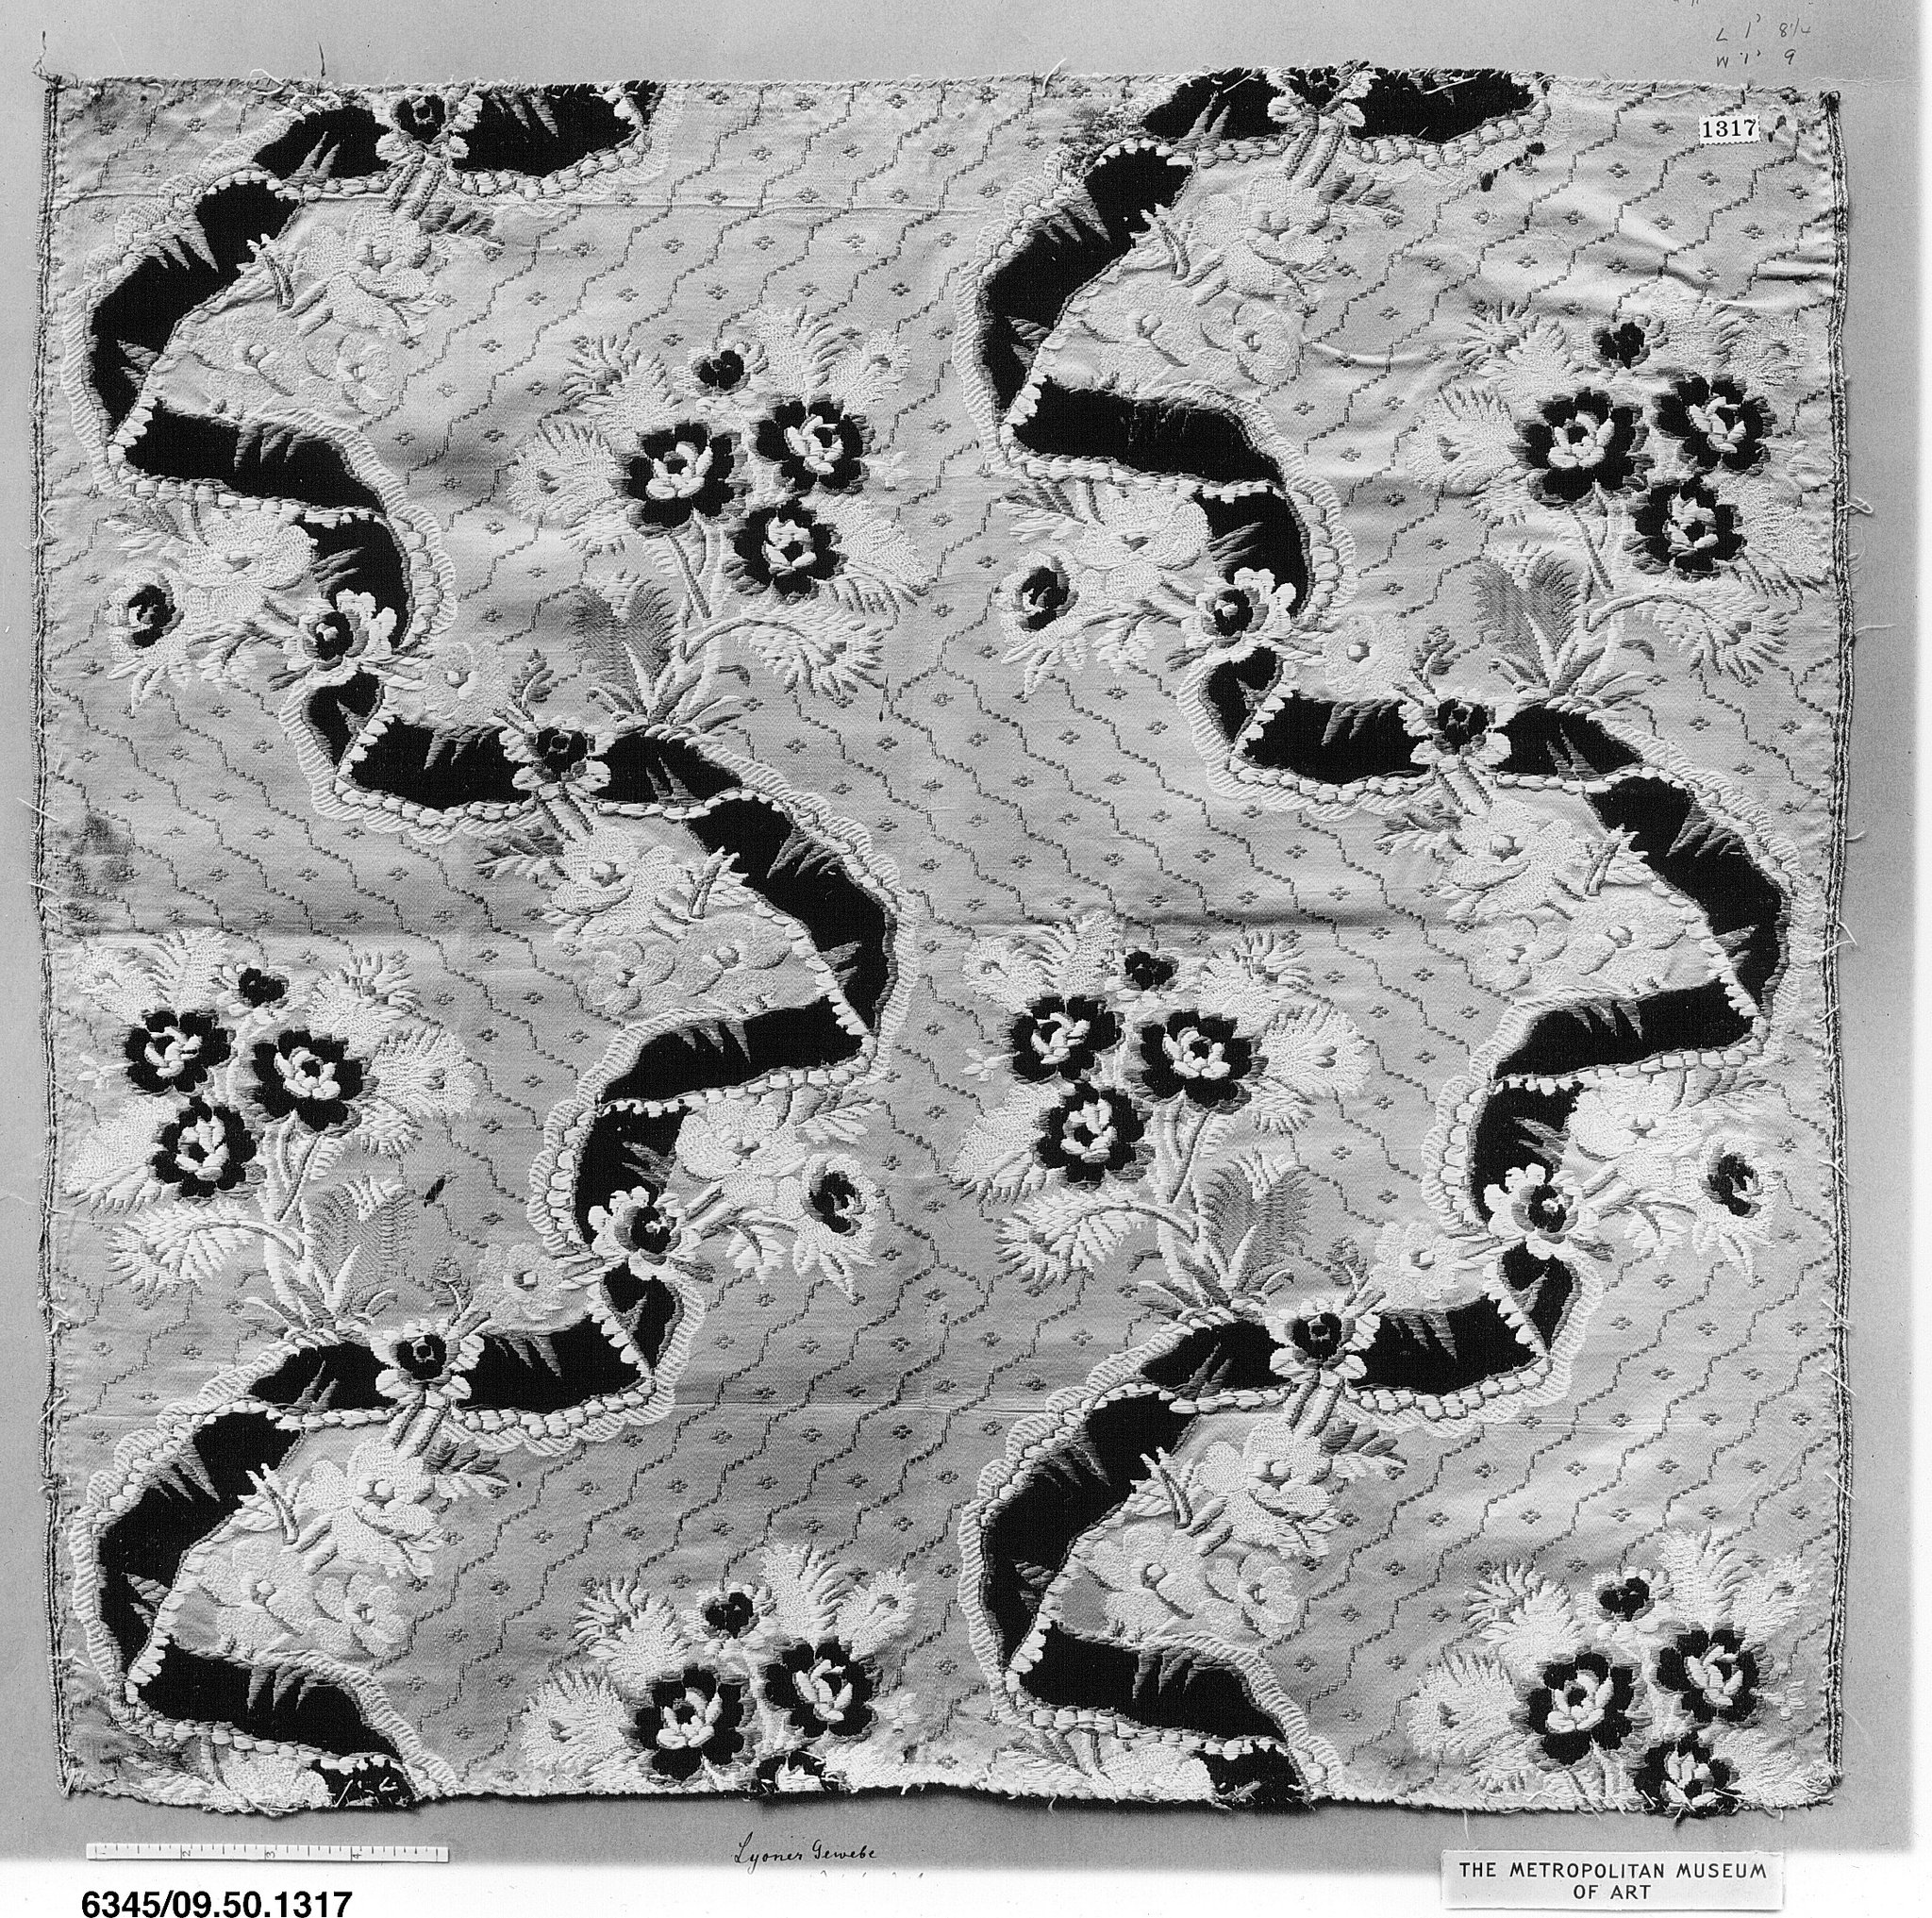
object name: piece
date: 1760-1770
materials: silk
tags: flowers,leaves